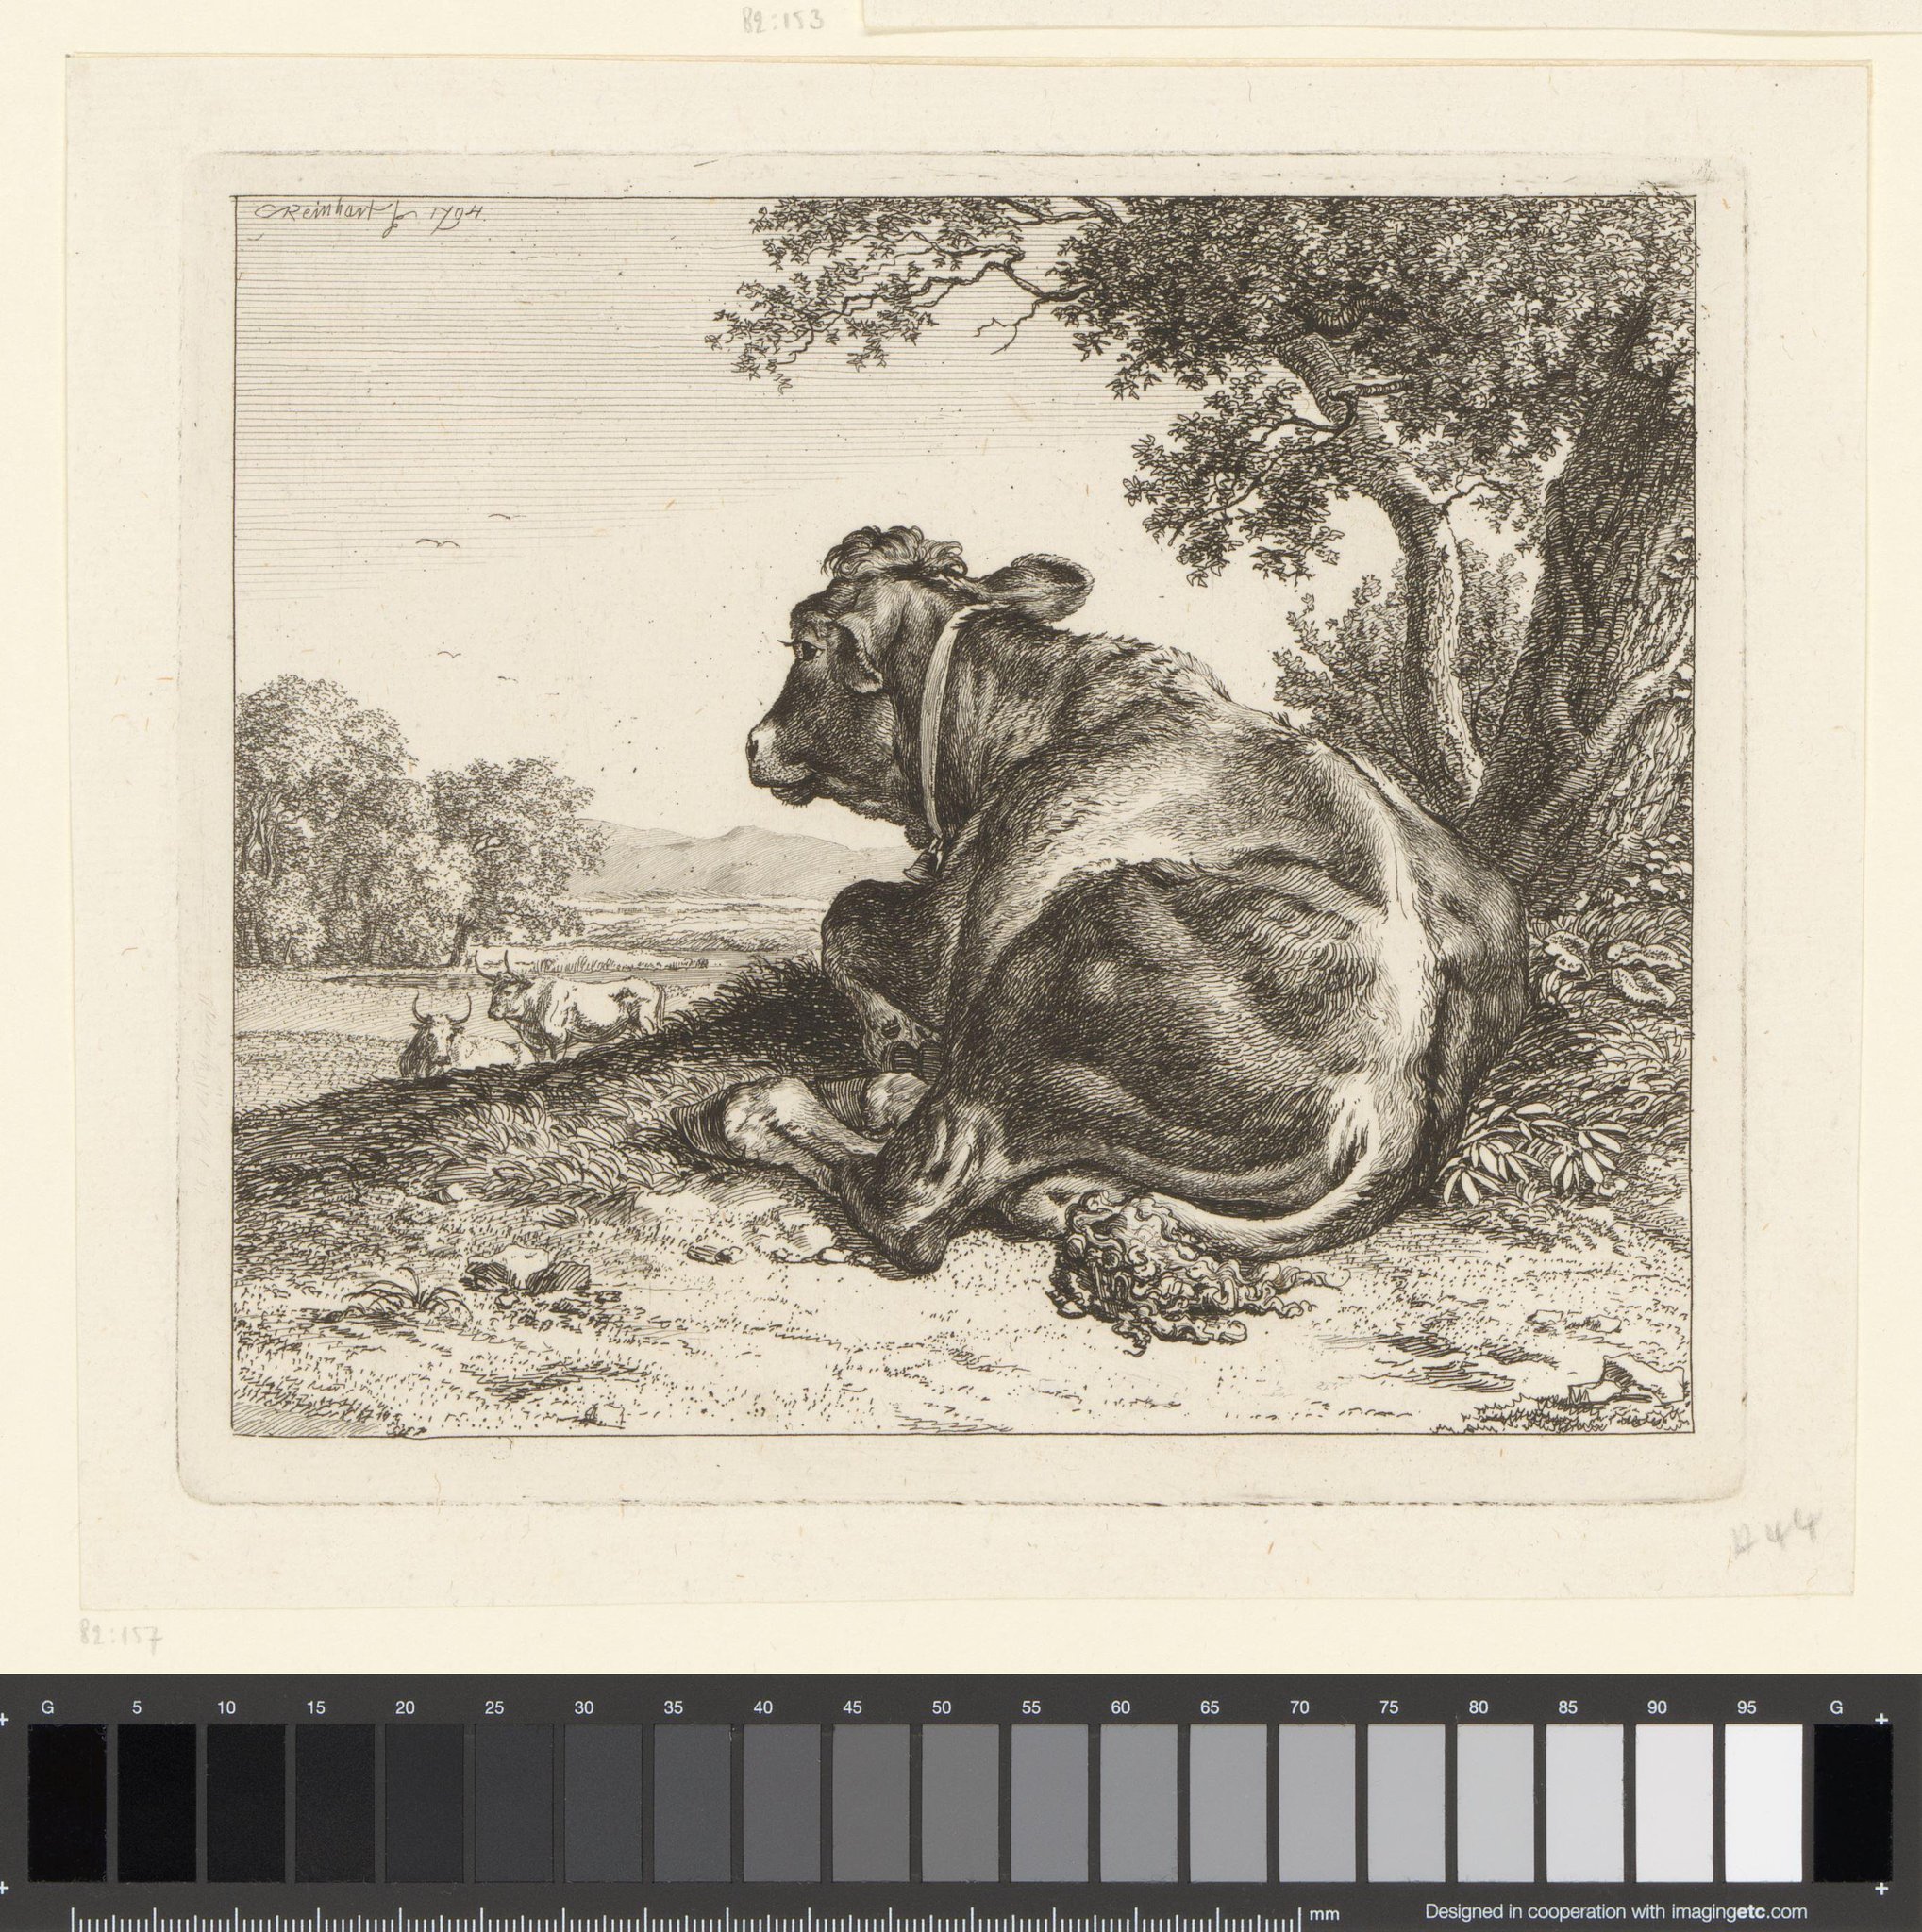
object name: print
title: Jonge stier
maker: johann christian reinhart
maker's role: print maker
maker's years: 1761-1847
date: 1794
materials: paper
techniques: etching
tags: bull, landscapes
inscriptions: collector's mark: Lugt 2760, collector's mark: Lugt 2228